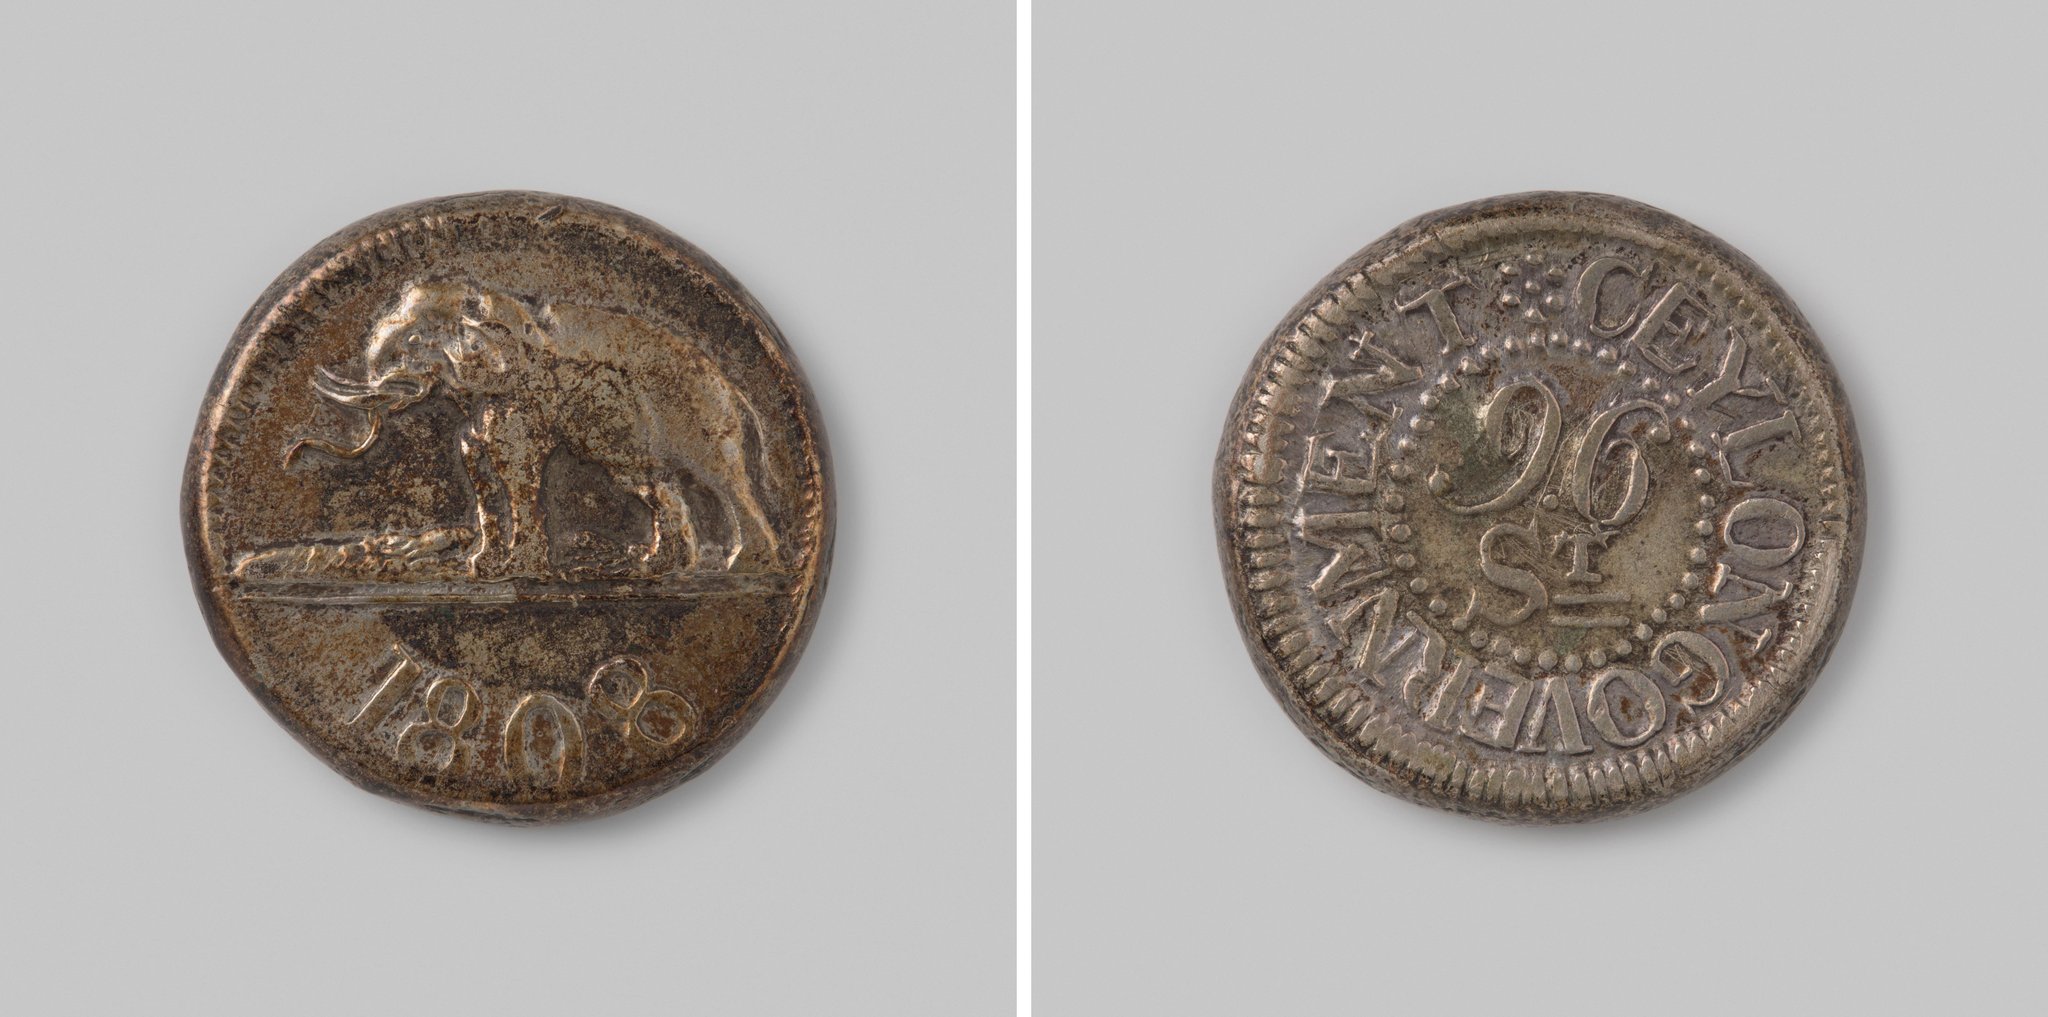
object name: coin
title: Dubbele rixdollar van 96 stivers van Sri Lanka, Ceylon, 1808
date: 1808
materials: silver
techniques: striking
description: Zilveren munt. Voorzijde: lopende olifant naar links. In afsnede jaartal onderaan. Keerzijde: binnen cirkel van stippen in twee regels waarde-aanduiding: 96 St. Gladde rand. Geslagen in Ceylon.